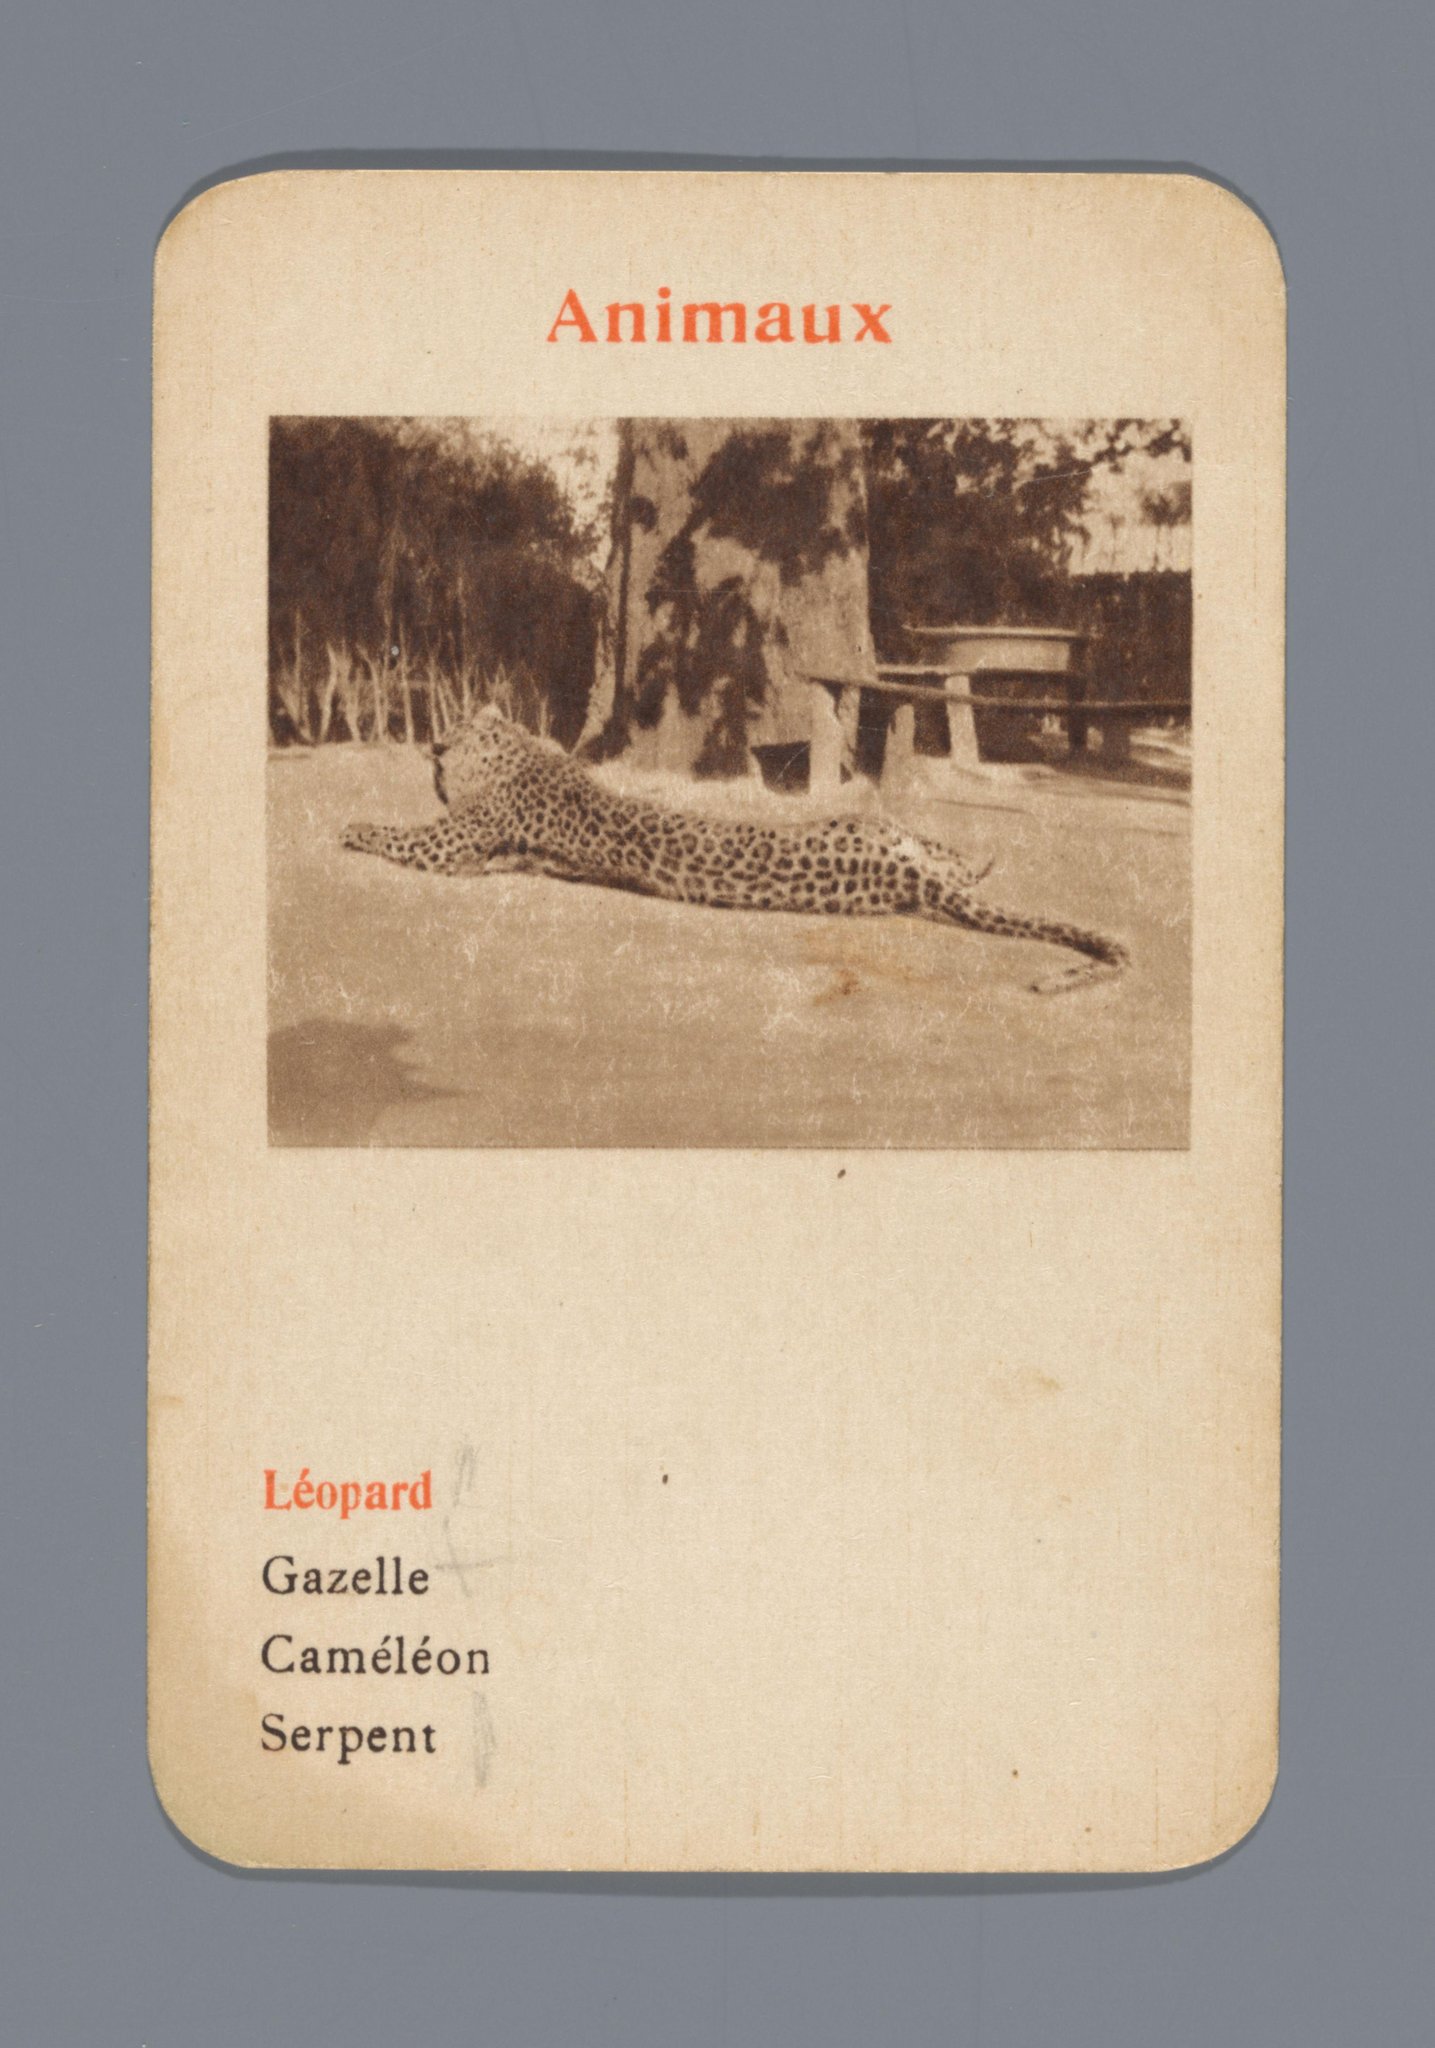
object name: card game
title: Léopard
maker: Anonymous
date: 1900-1920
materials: cardboard, paper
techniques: rotogravure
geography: france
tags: beasts of prey, predatory animals: leopard, card games